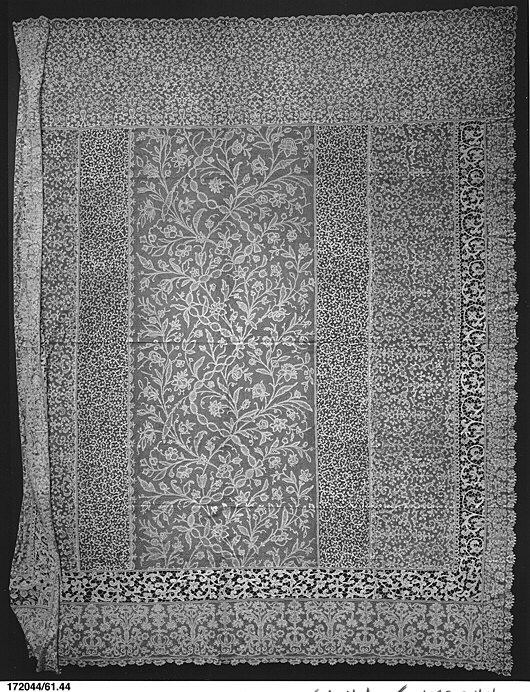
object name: tablecloth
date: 1601-1800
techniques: lace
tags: flowers